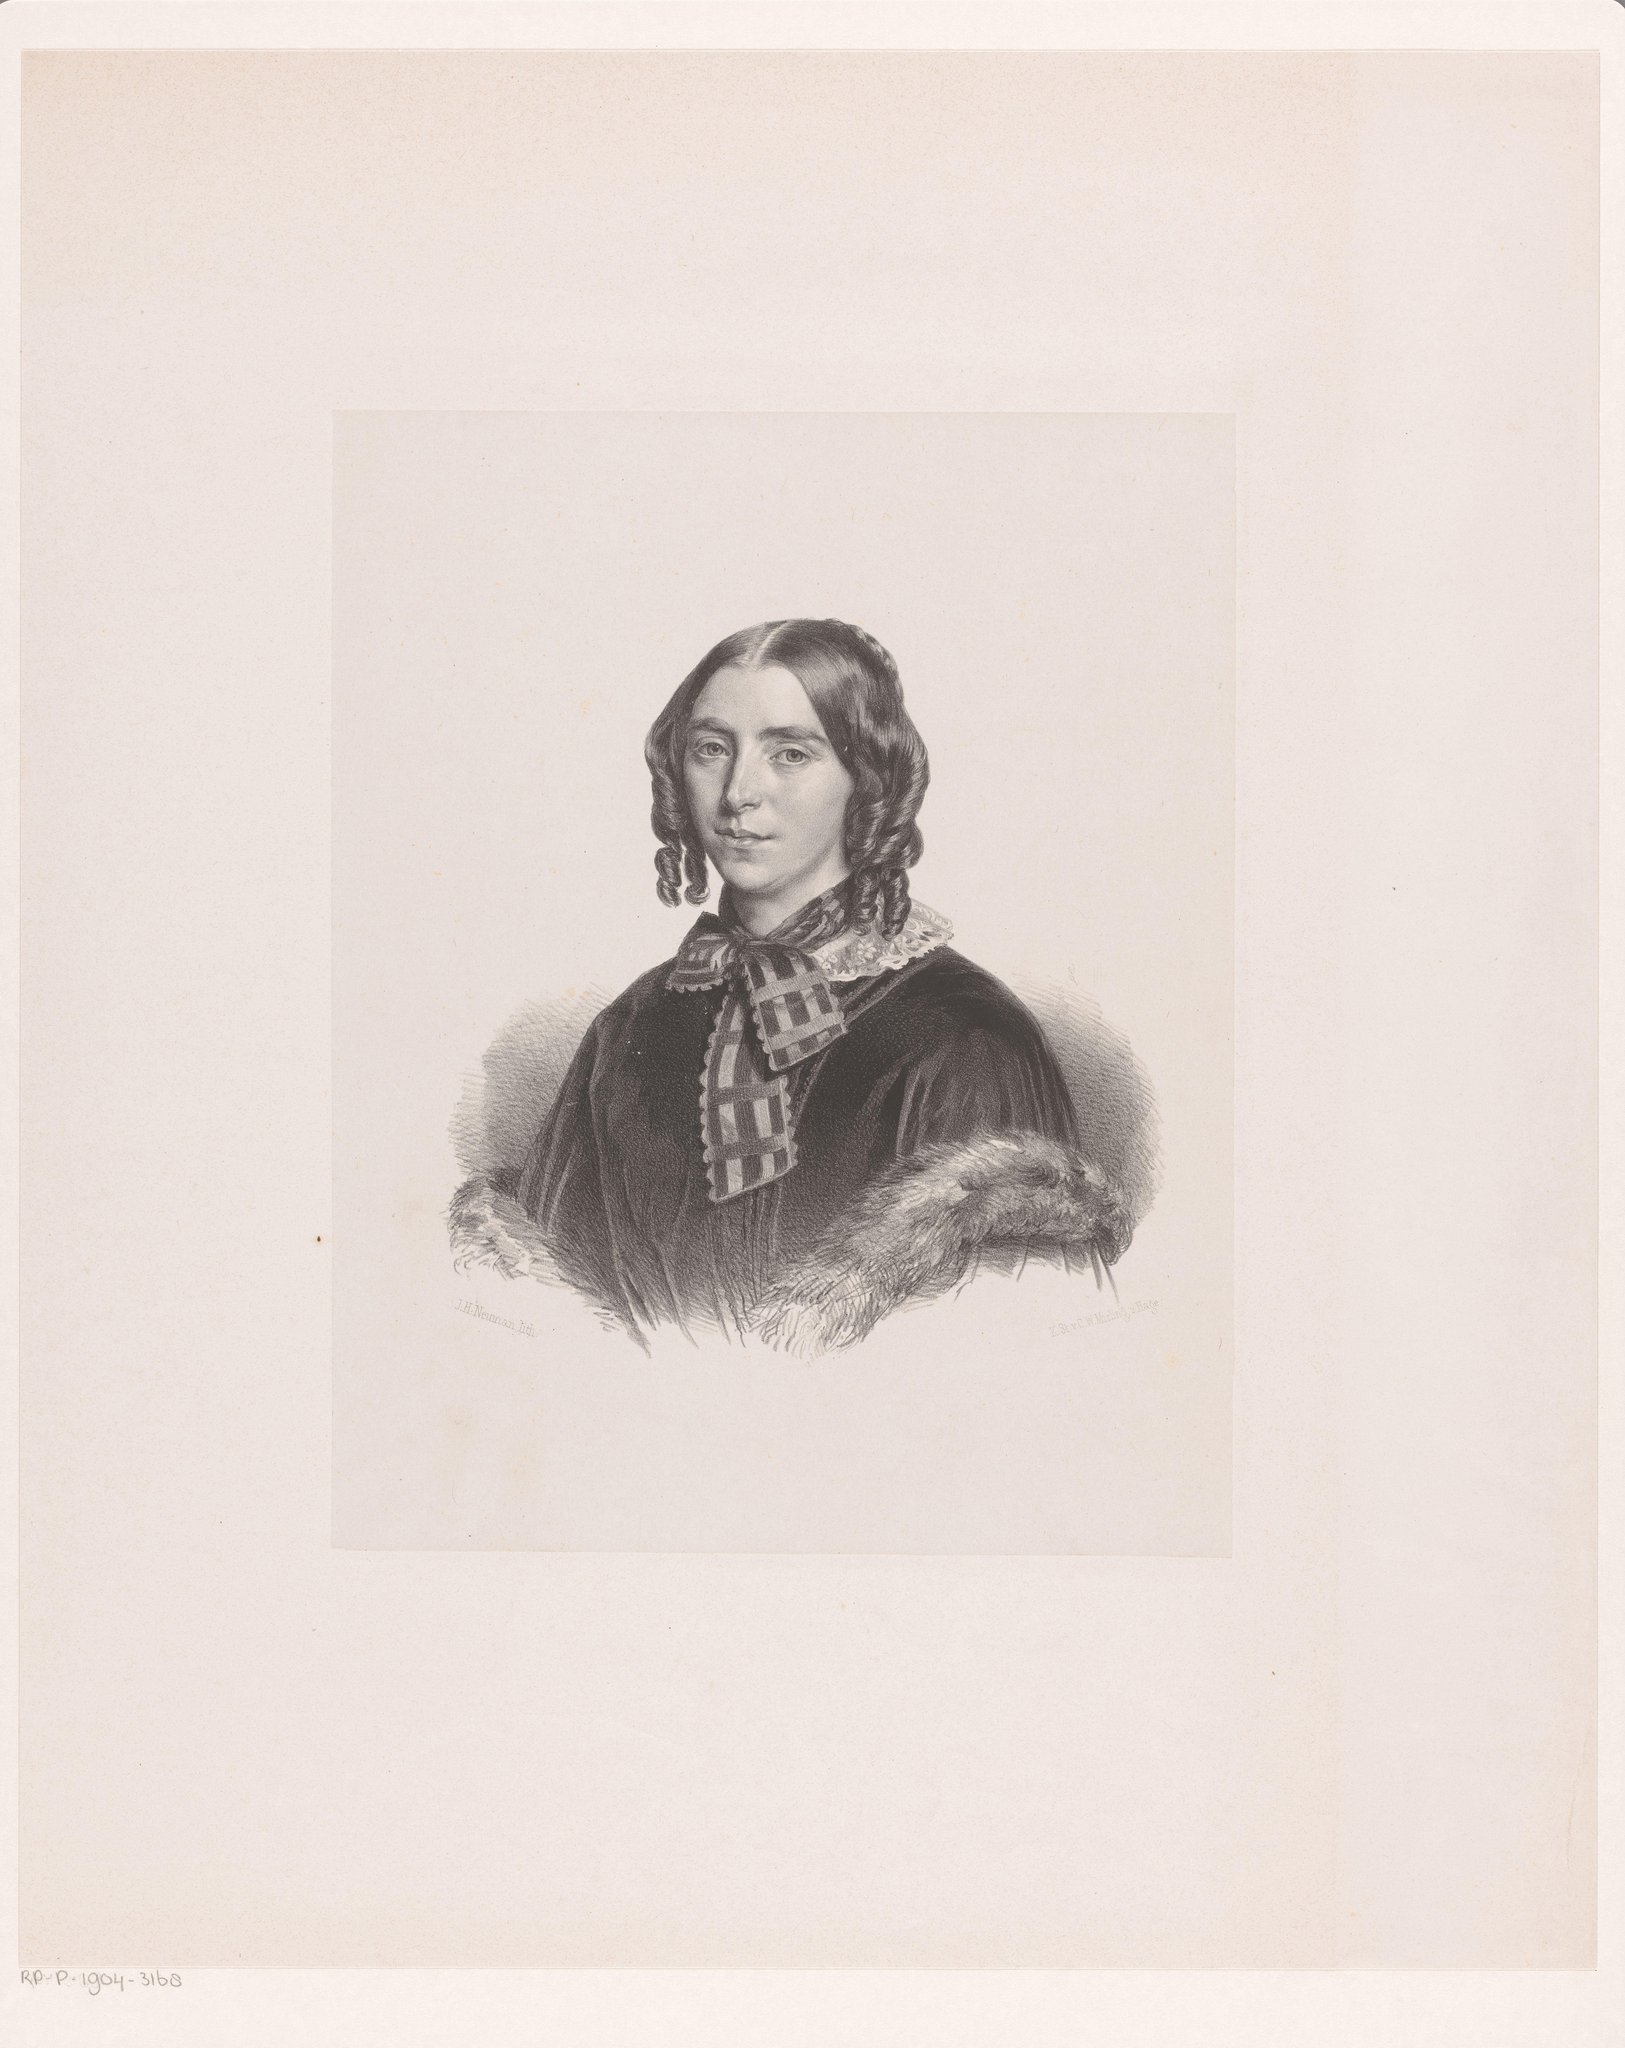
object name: print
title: Portret van een onbekende vrouw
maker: johan heinrich neuman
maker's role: draughtsman, painter, print maker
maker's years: 1819-1898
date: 1847-1865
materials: paper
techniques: lithograph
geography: the hague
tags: anonymous historical person portrayed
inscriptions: collector's mark: Lugt 2228